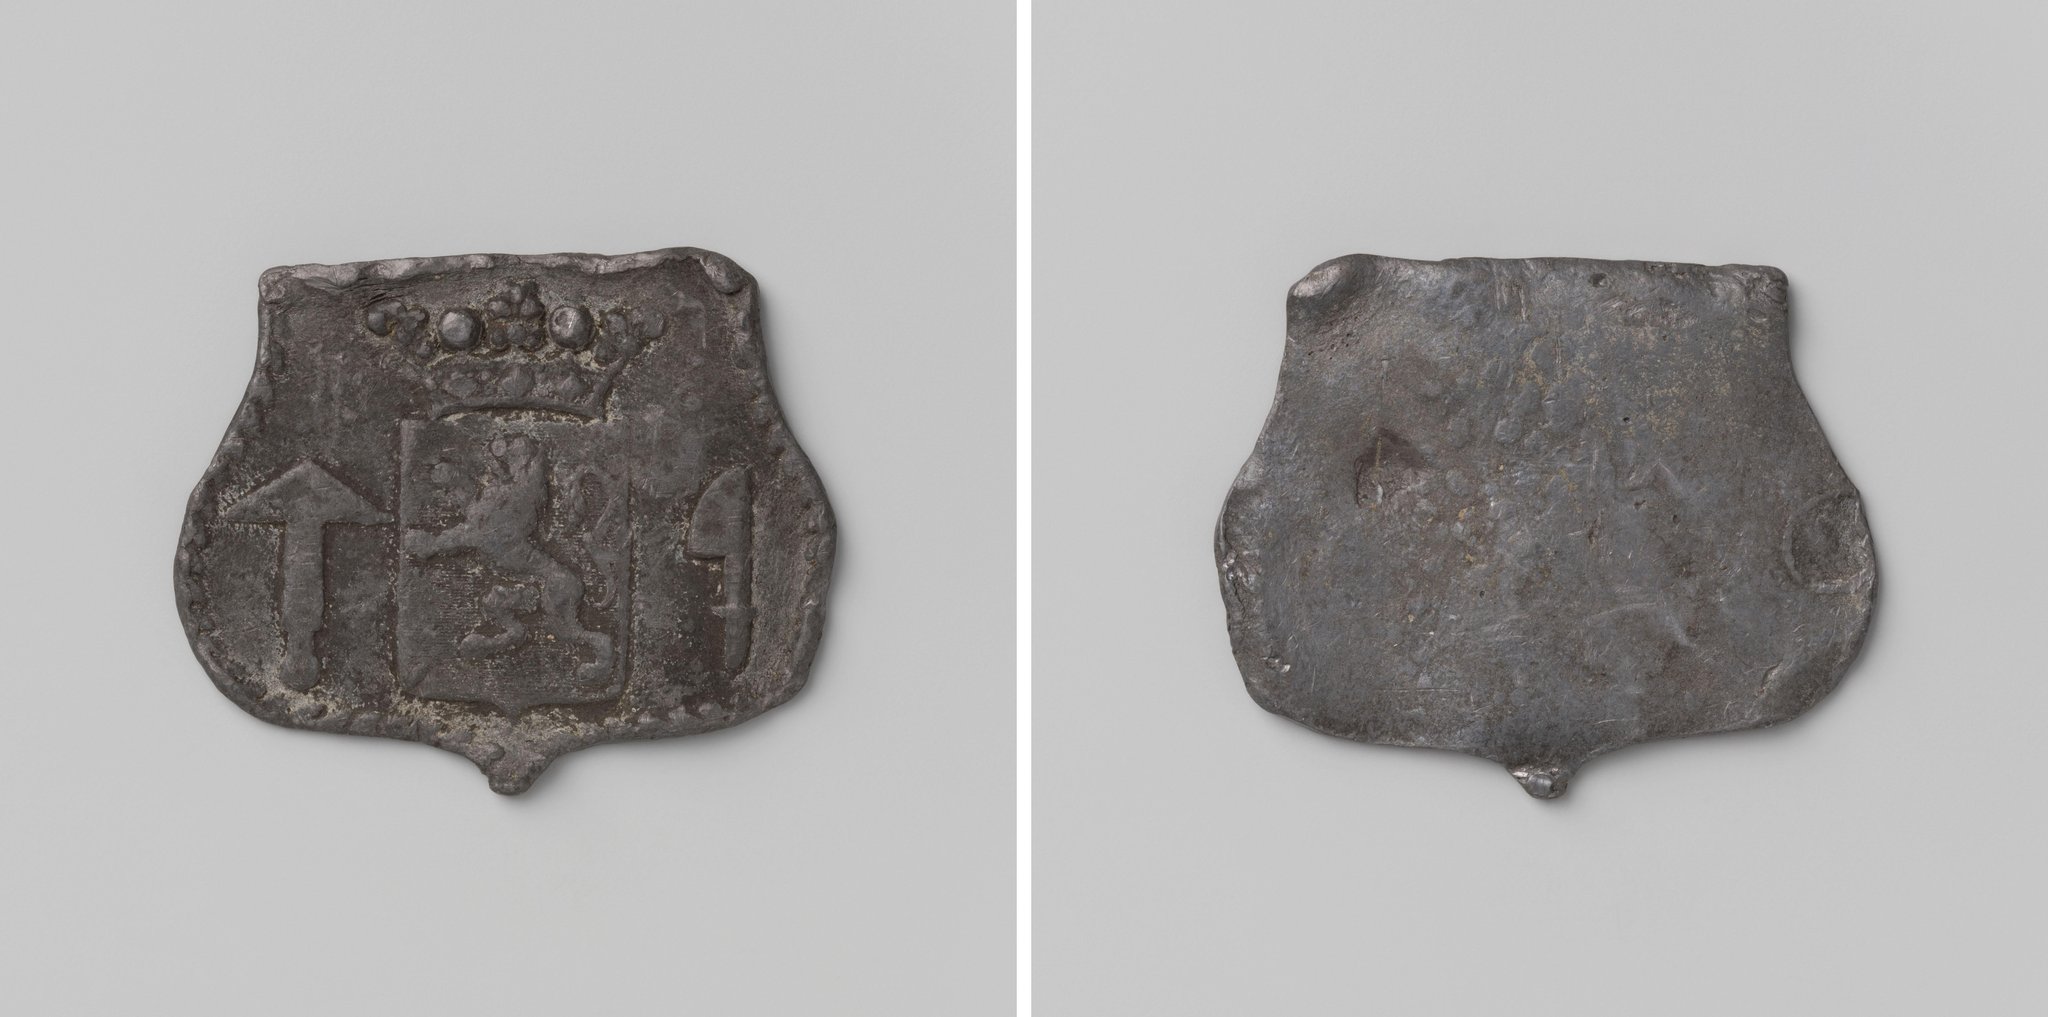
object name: insignia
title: Loodgieters- en leidekkersgilde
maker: Anonymous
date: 1550-1750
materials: lead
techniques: casting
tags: netherlands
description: Eenzijdig loden draagteken in vorm van wapenschild. Voorzijde: gekroond wapenschild tussen loodgietershamer en mes of hamer. Keerzijde: blanco.